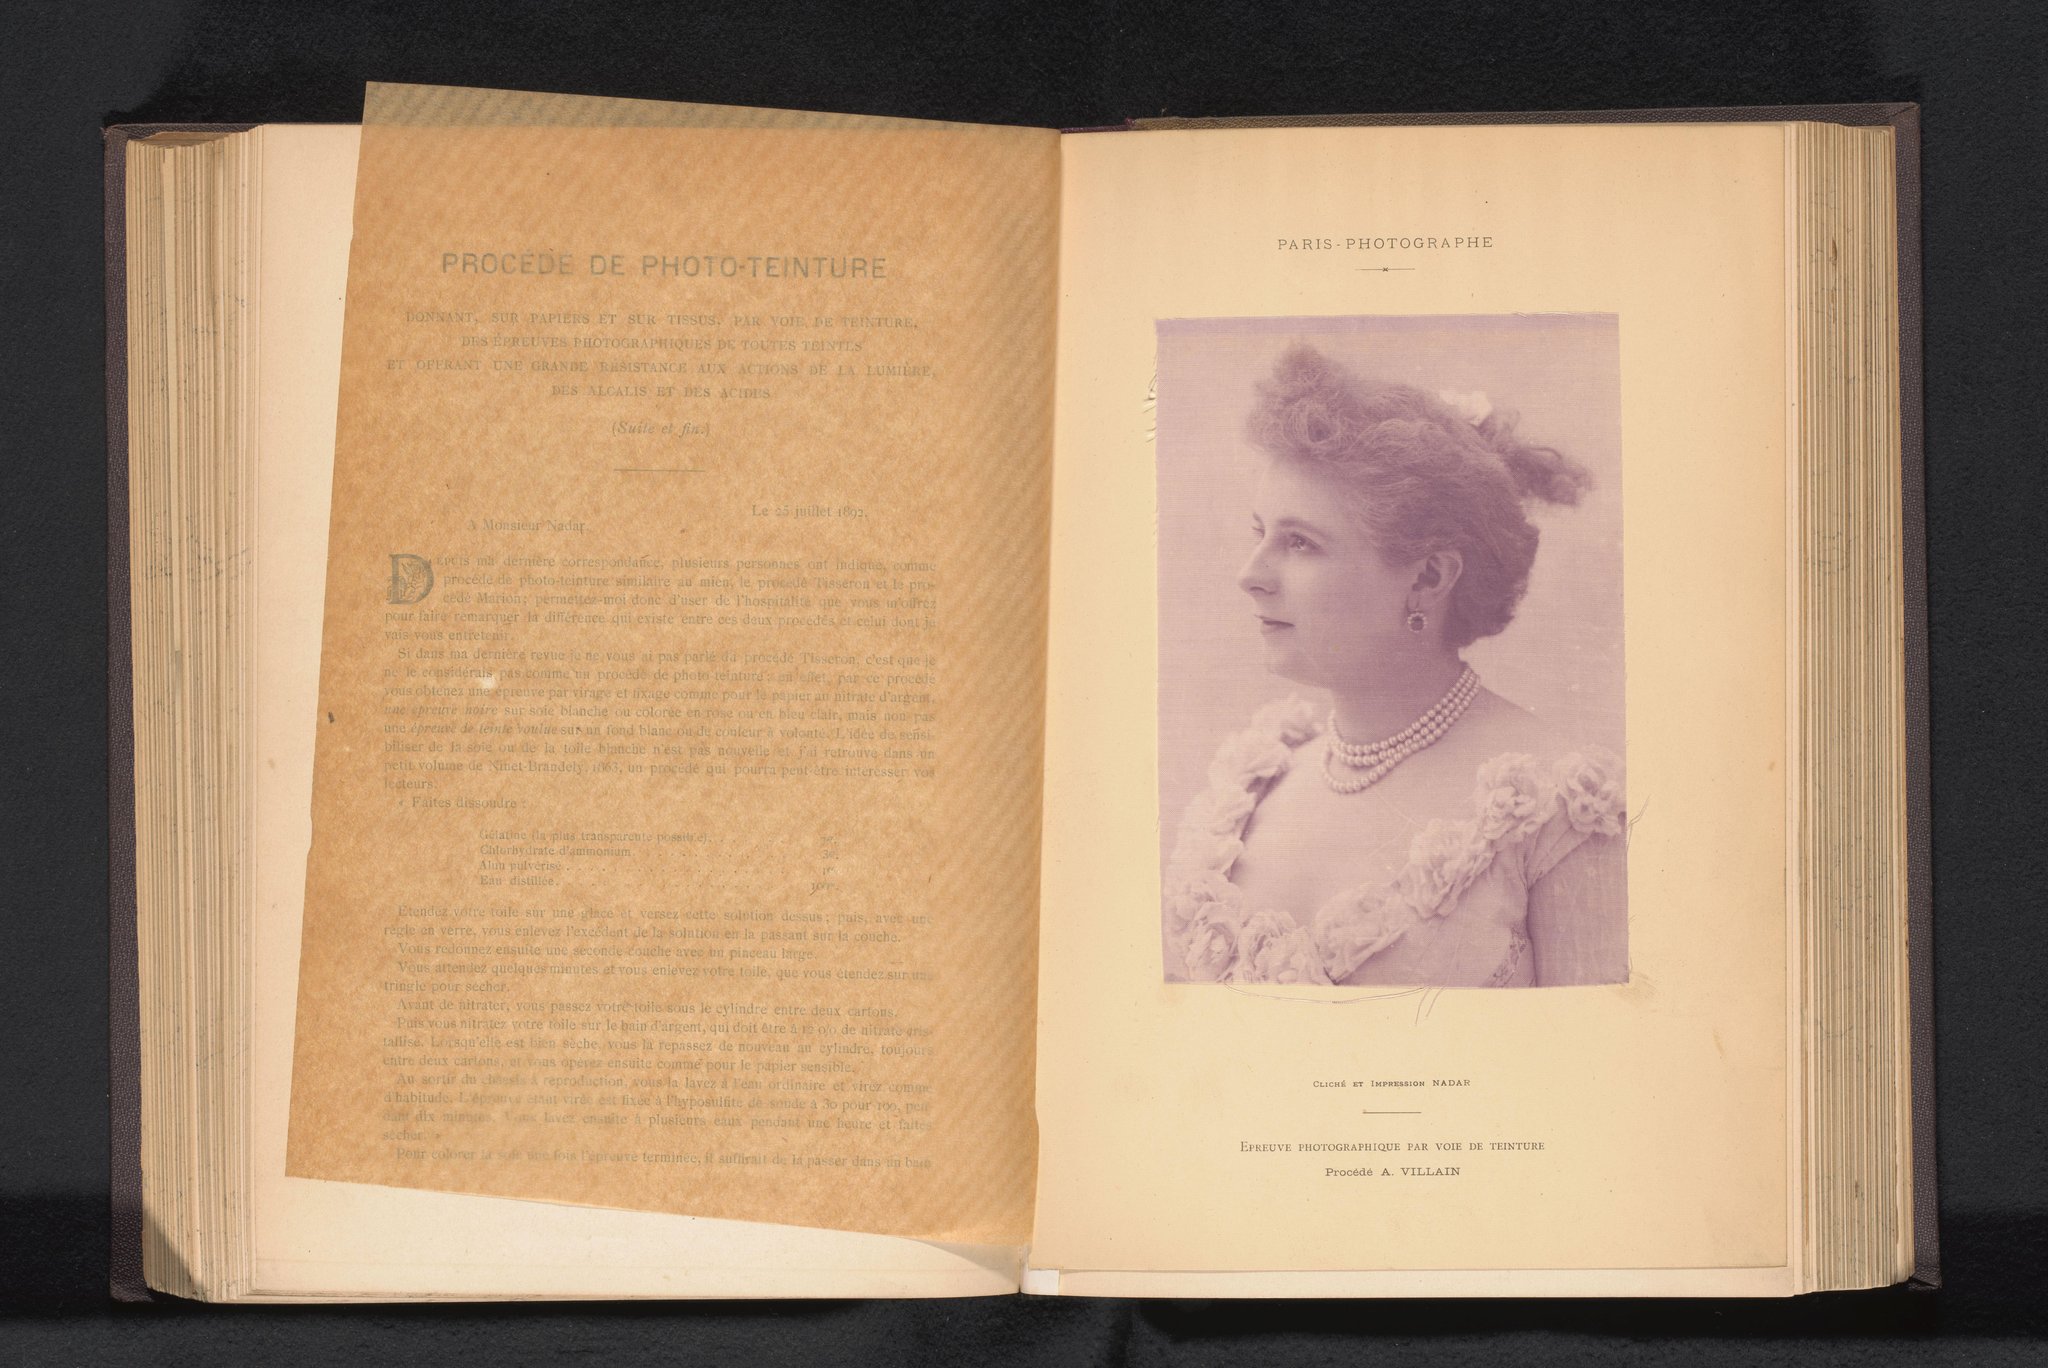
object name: page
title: Portret van een onbekende vrouw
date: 1882-1892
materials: textile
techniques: photo-tinted print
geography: france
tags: adult woman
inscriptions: inscription: ‘Epreuve photographique par voie de teinture Procédé A. Villain’